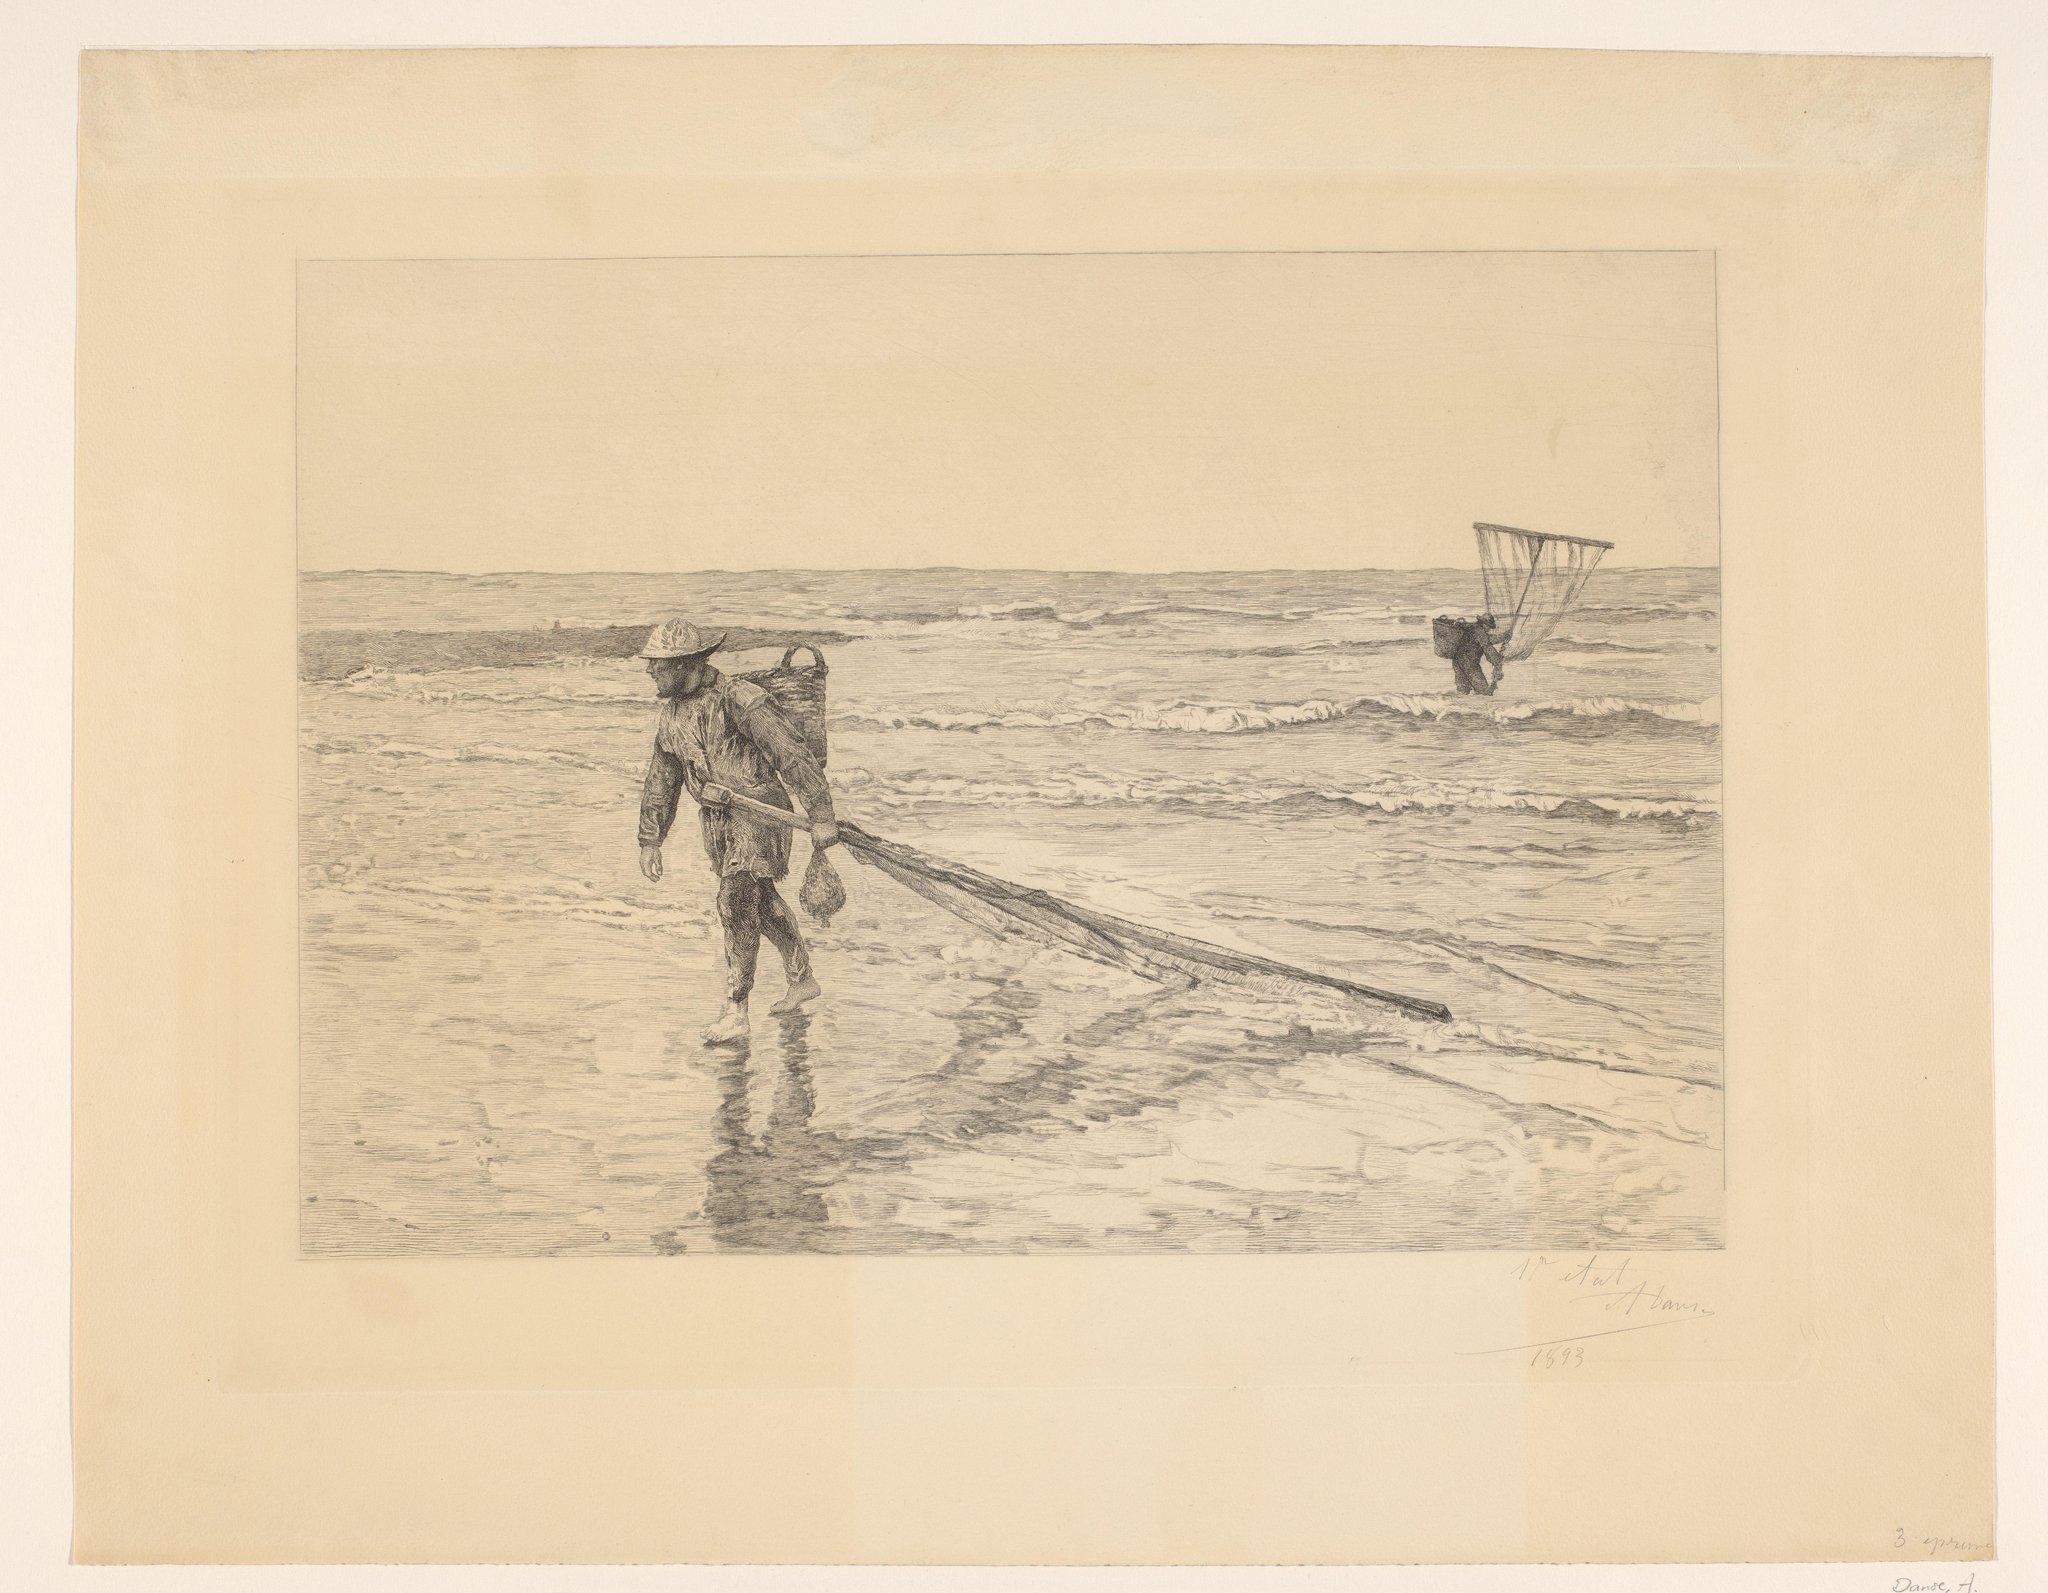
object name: print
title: Schelpenvissers met netten in de branding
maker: auguste danse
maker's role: print maker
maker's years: 1829-1929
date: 1893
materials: paper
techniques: etching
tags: shell fishery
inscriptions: collector's mark: Lugt 2228, annotation: ‘1er etat; 3 epreuves’